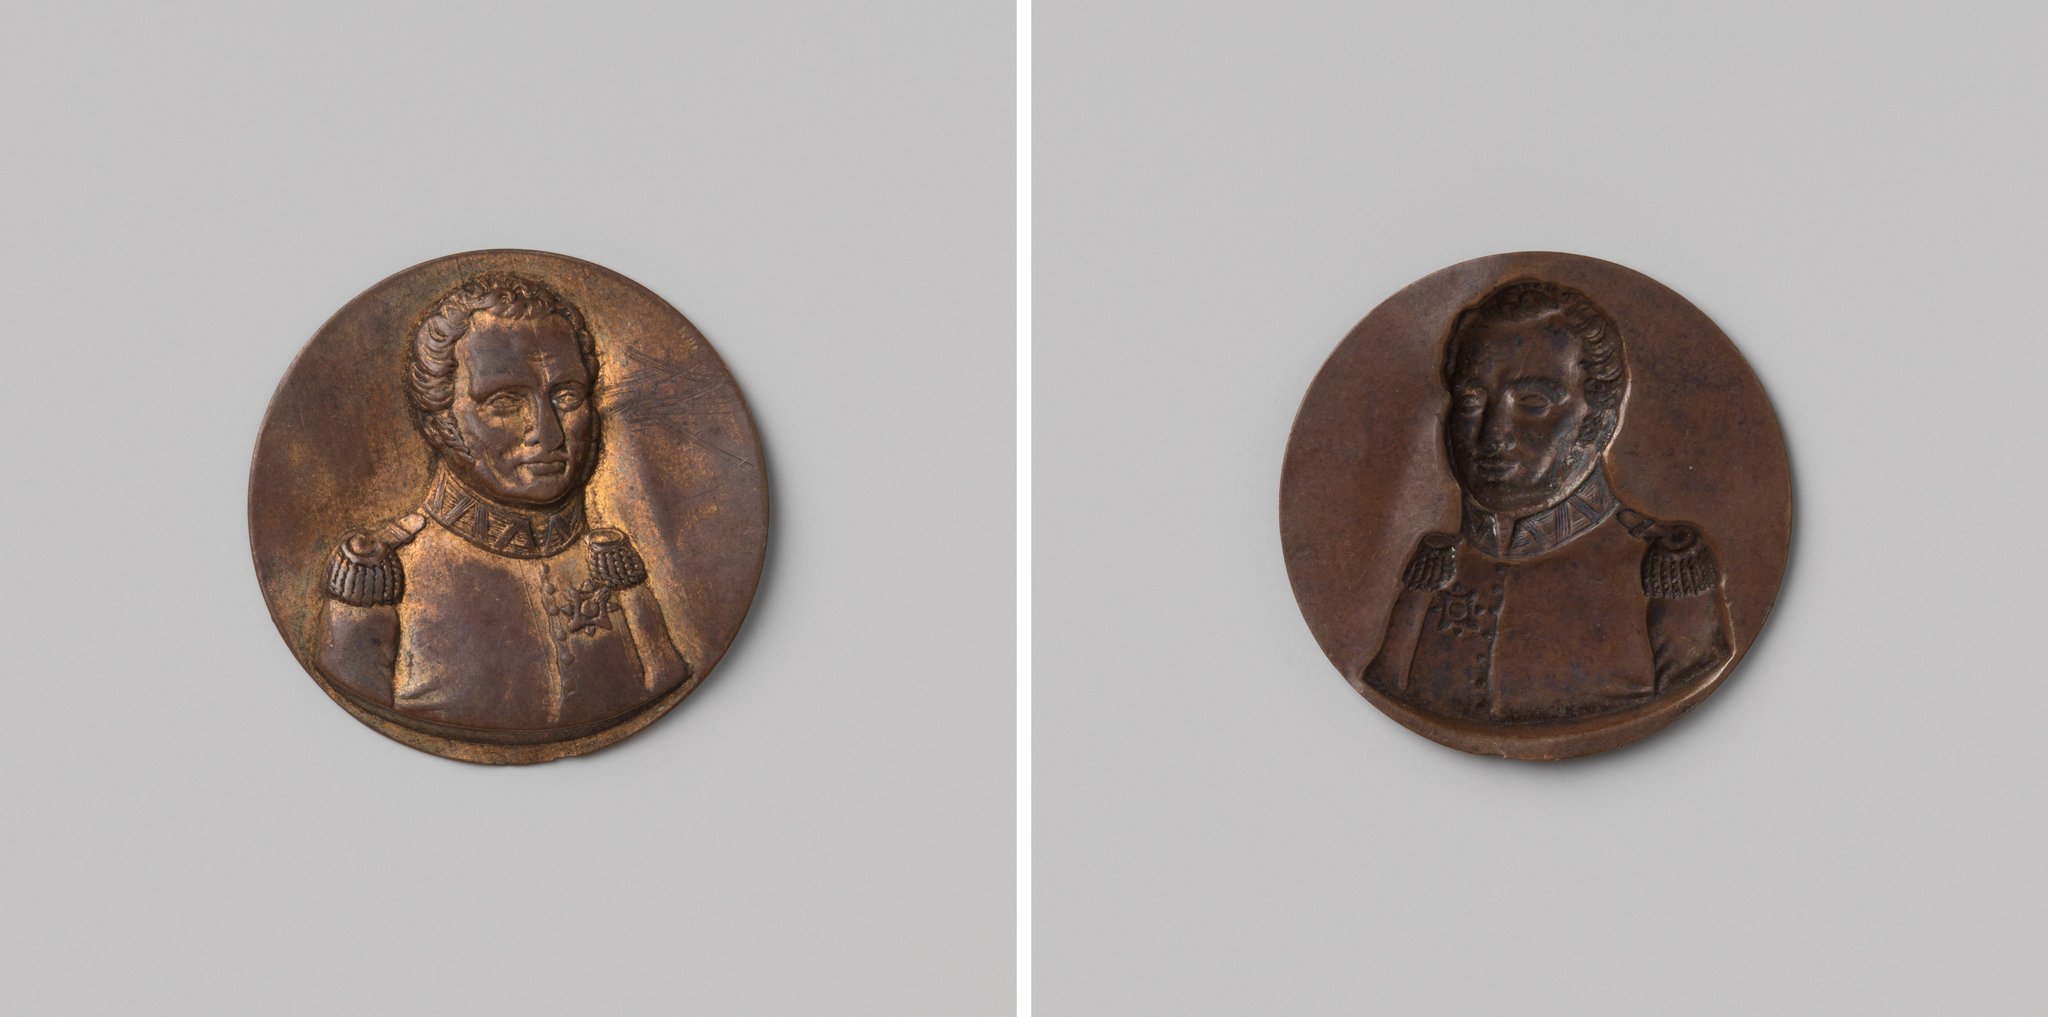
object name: plate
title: Willem I, koning der Nederlanden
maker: Anonymous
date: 1815-1843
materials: copper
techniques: gilding, striking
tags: the hague, berlin, william i of the netherlands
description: eenzijdig plaatje. Voorzijde: borststuk man naar rechts. Keerzijde: blanco